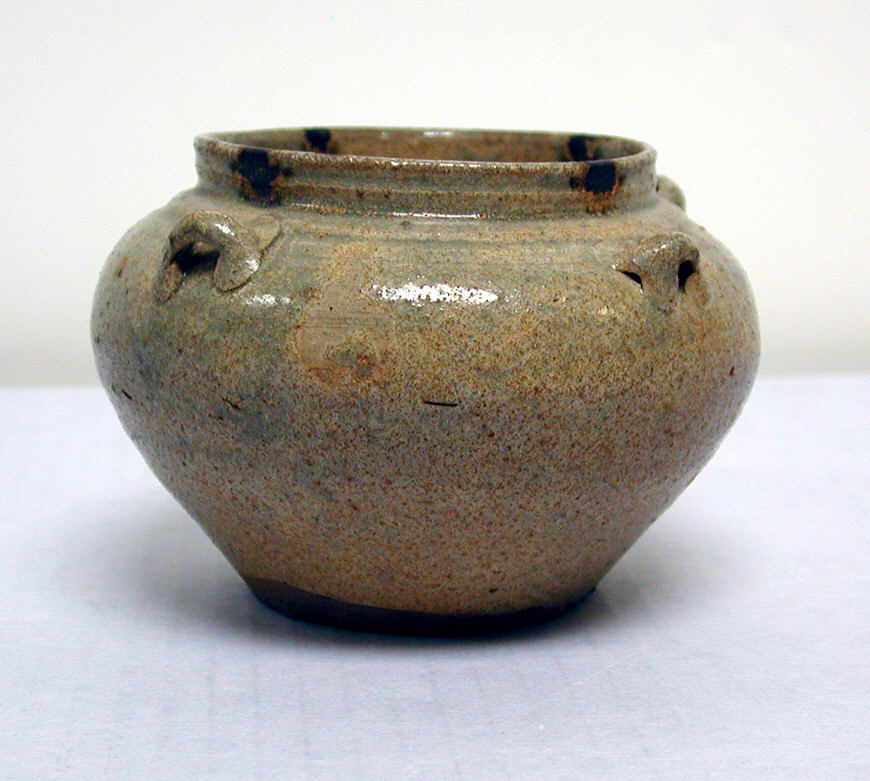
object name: jar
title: Jar (Guan)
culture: chinese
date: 301-400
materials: stoneware